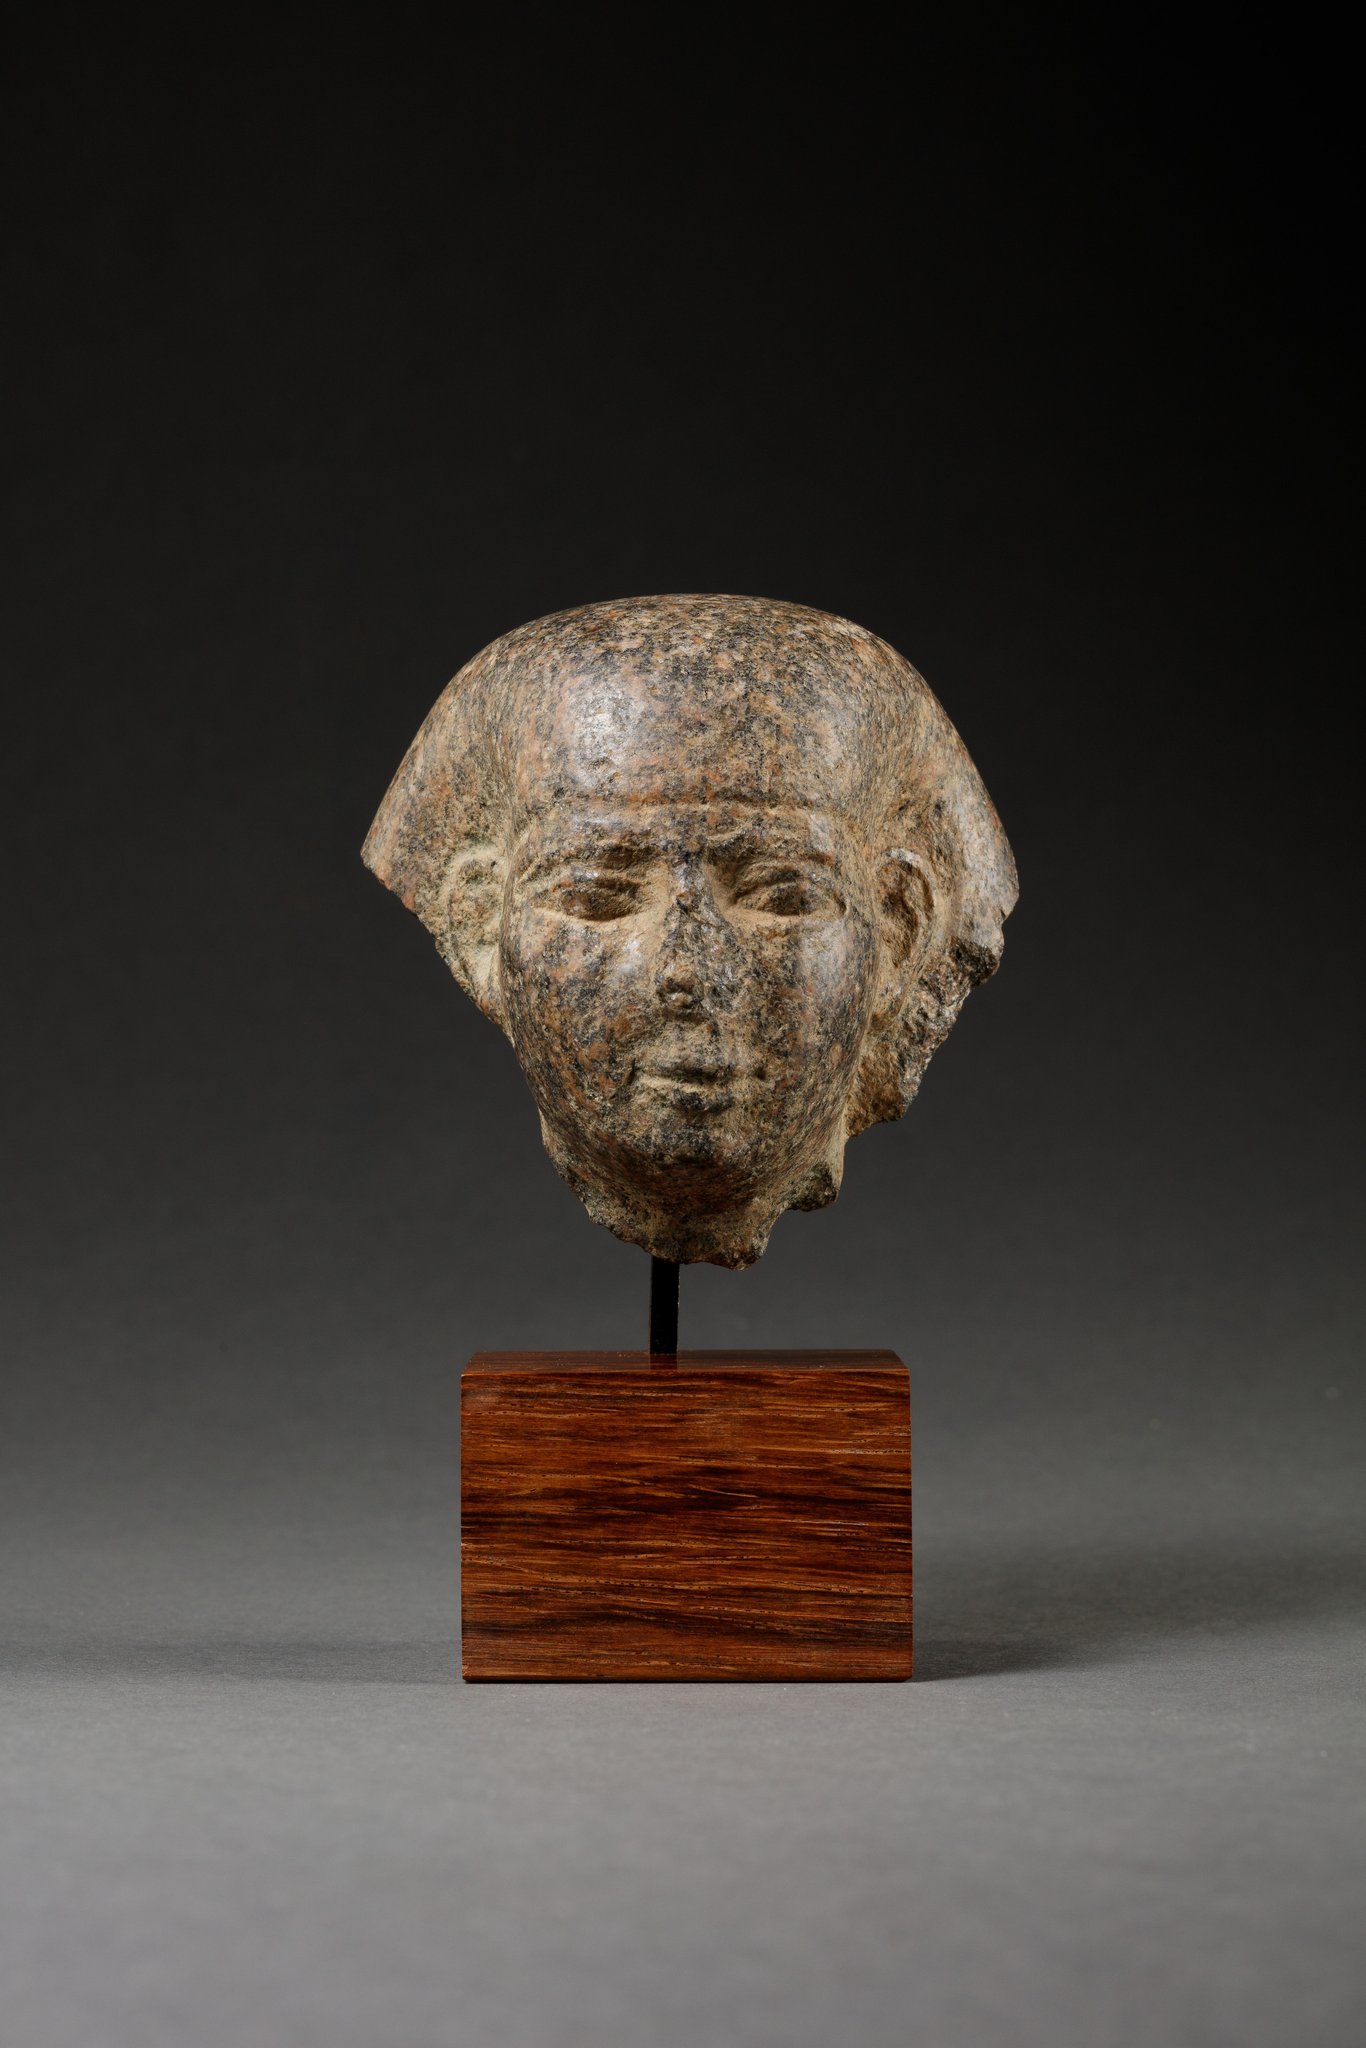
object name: head of a man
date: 1802-1650 BCE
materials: granite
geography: egypt